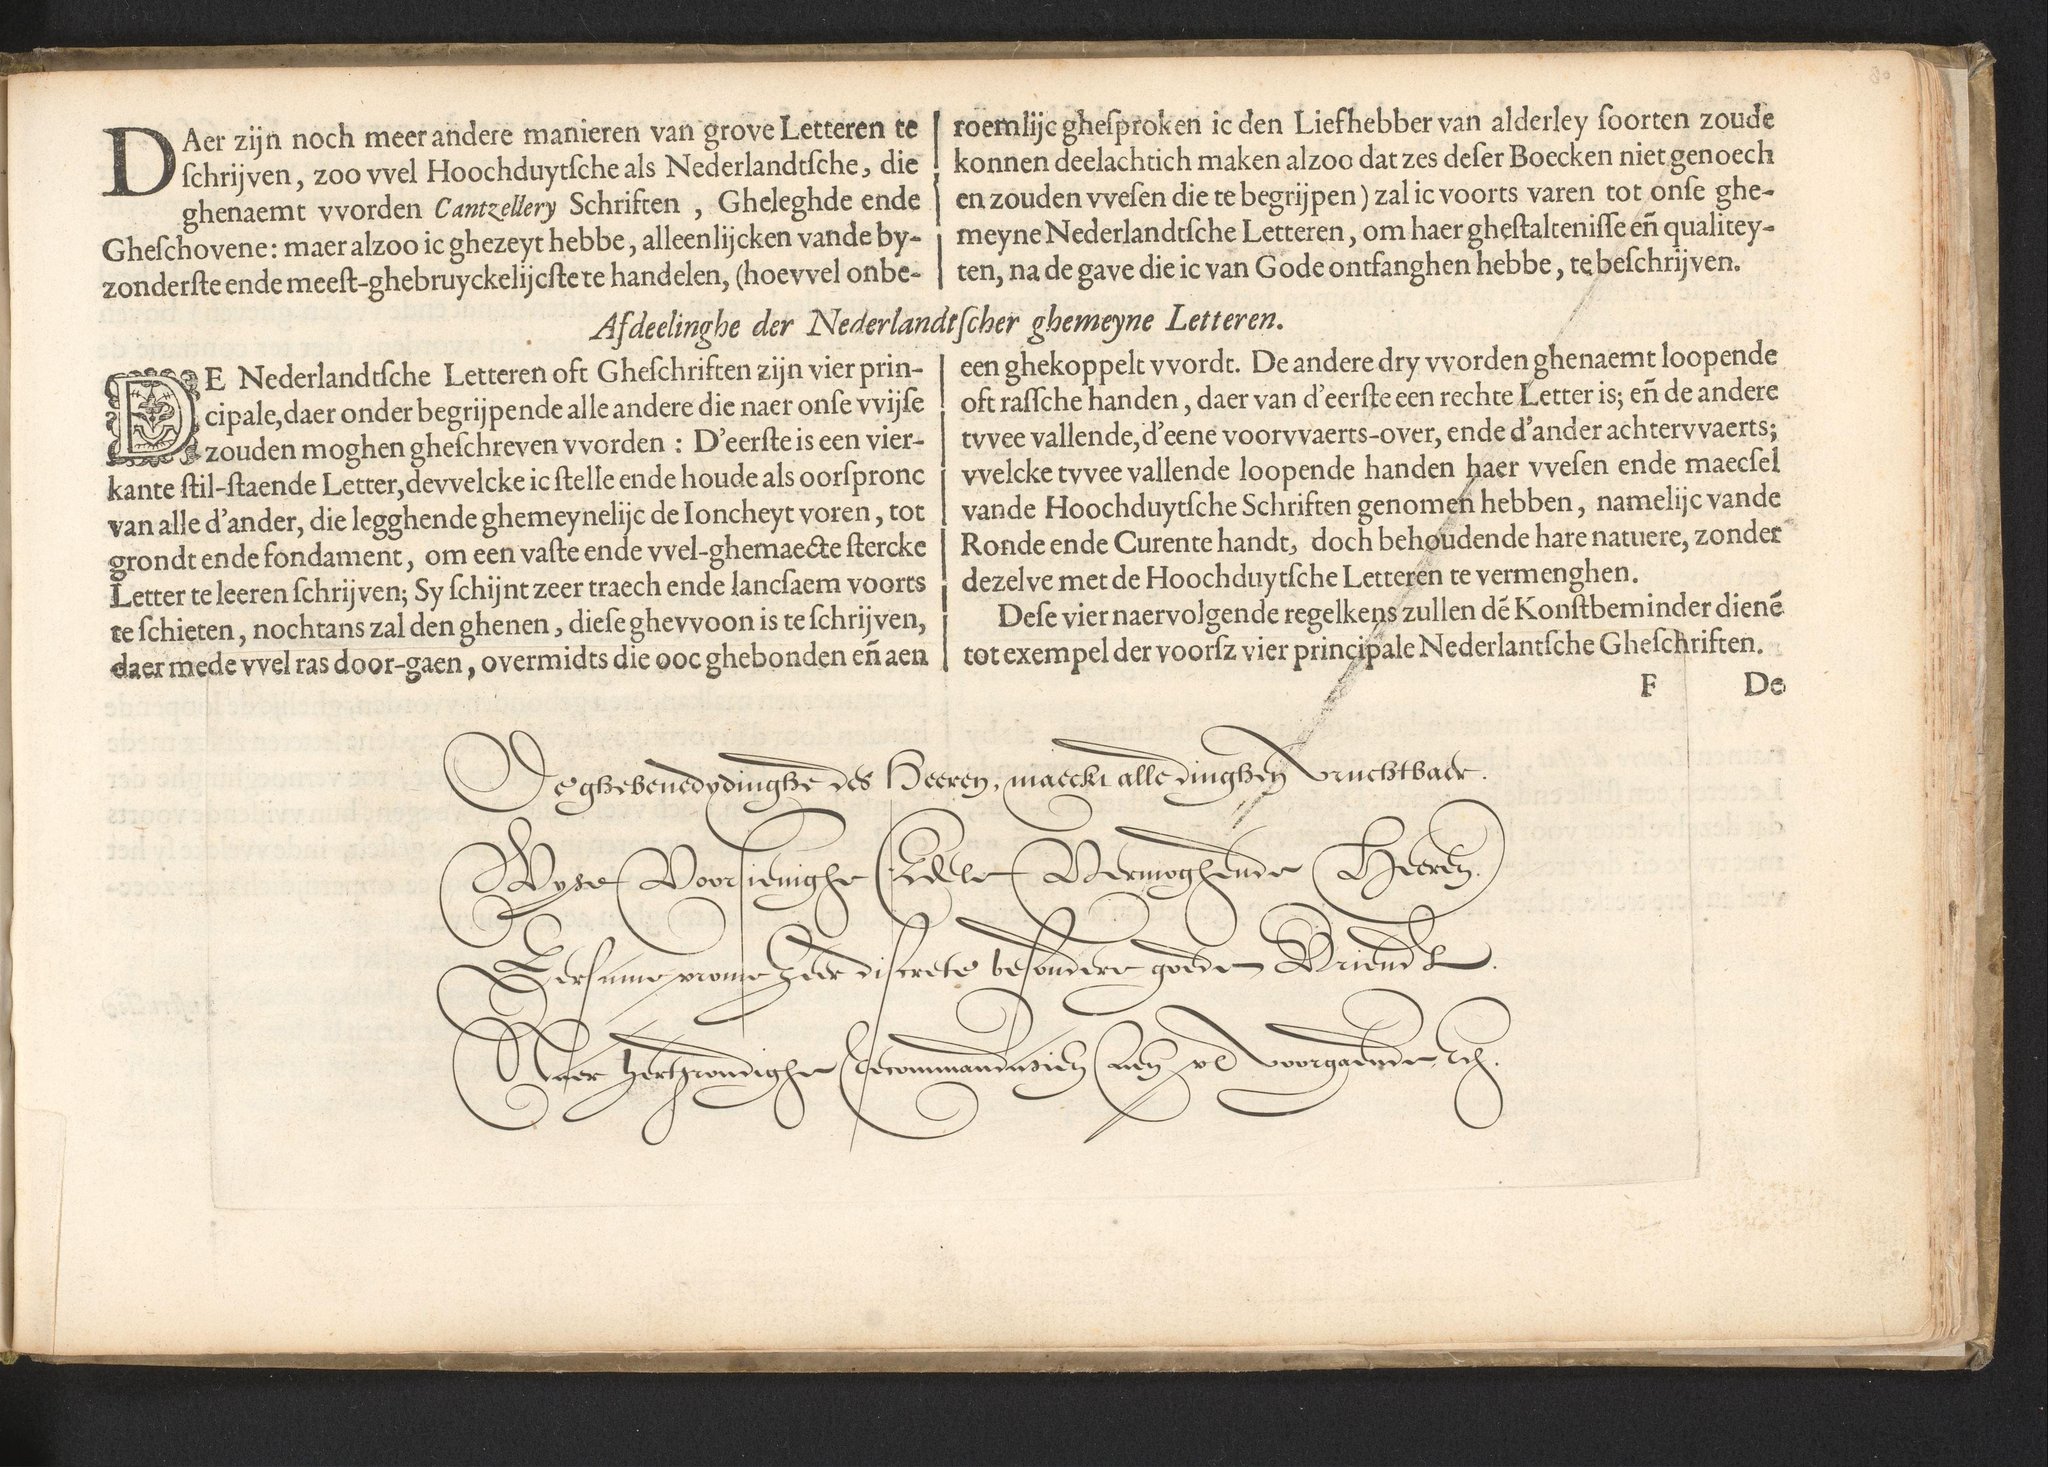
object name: print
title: Onderrichtinghe der Nederlandtsche grove ende kleyne letteren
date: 1605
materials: paper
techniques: engraving, letterpress printing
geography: rotterdam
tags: calligraphy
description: Folio F1r met een beschrijving en een schrijfvoorbeeld van vier Nederlandse 'ghemeyne letteren'. De tekst vangt aan met een kleine initiaal D. Het blad maakt deel uit van een album.